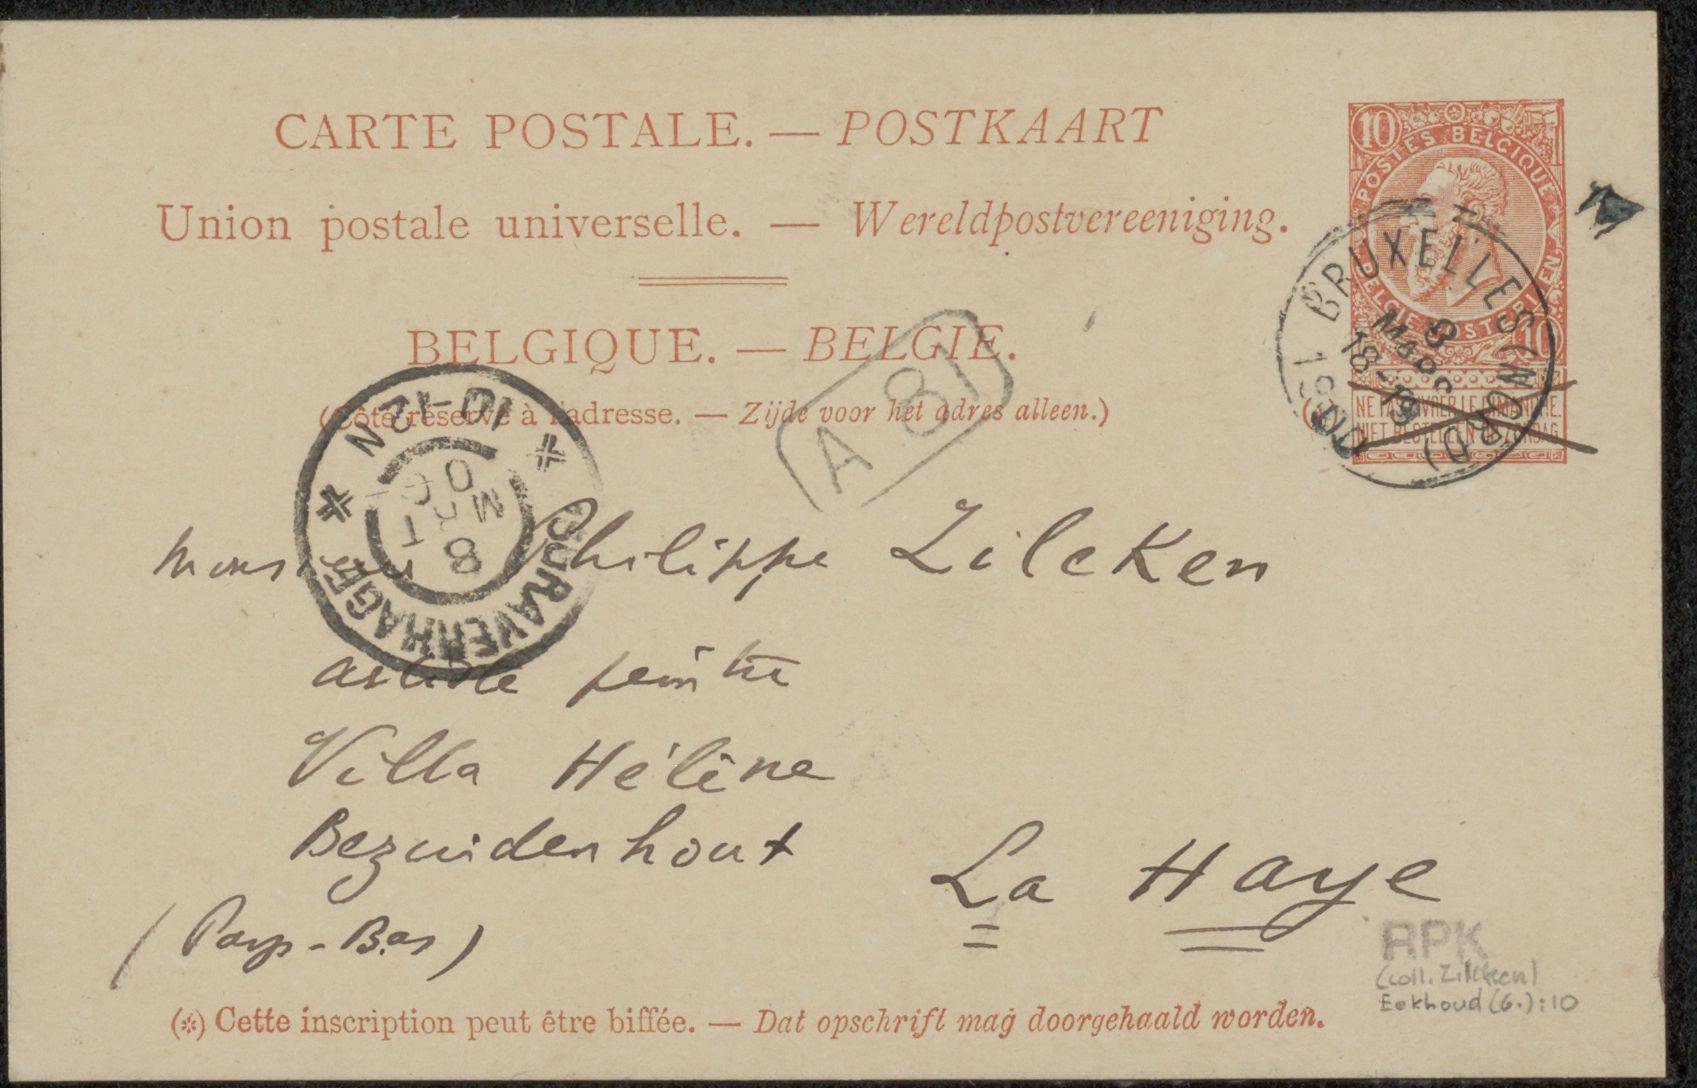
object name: postcard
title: Briefkaart aan Philip Zilcken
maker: georges eekhoud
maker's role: schrijver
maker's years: 1854-1927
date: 1900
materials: cardboard, ink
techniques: pen, writing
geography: brussels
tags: brussels, print maker, hippolyte emmanuel boulenger, the hague, painter, draughtsman, philip zilcken, photography, cinematography, painting (including book-illumination, miniature-painting), printed matter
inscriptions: collector's mark: ‘RPK’